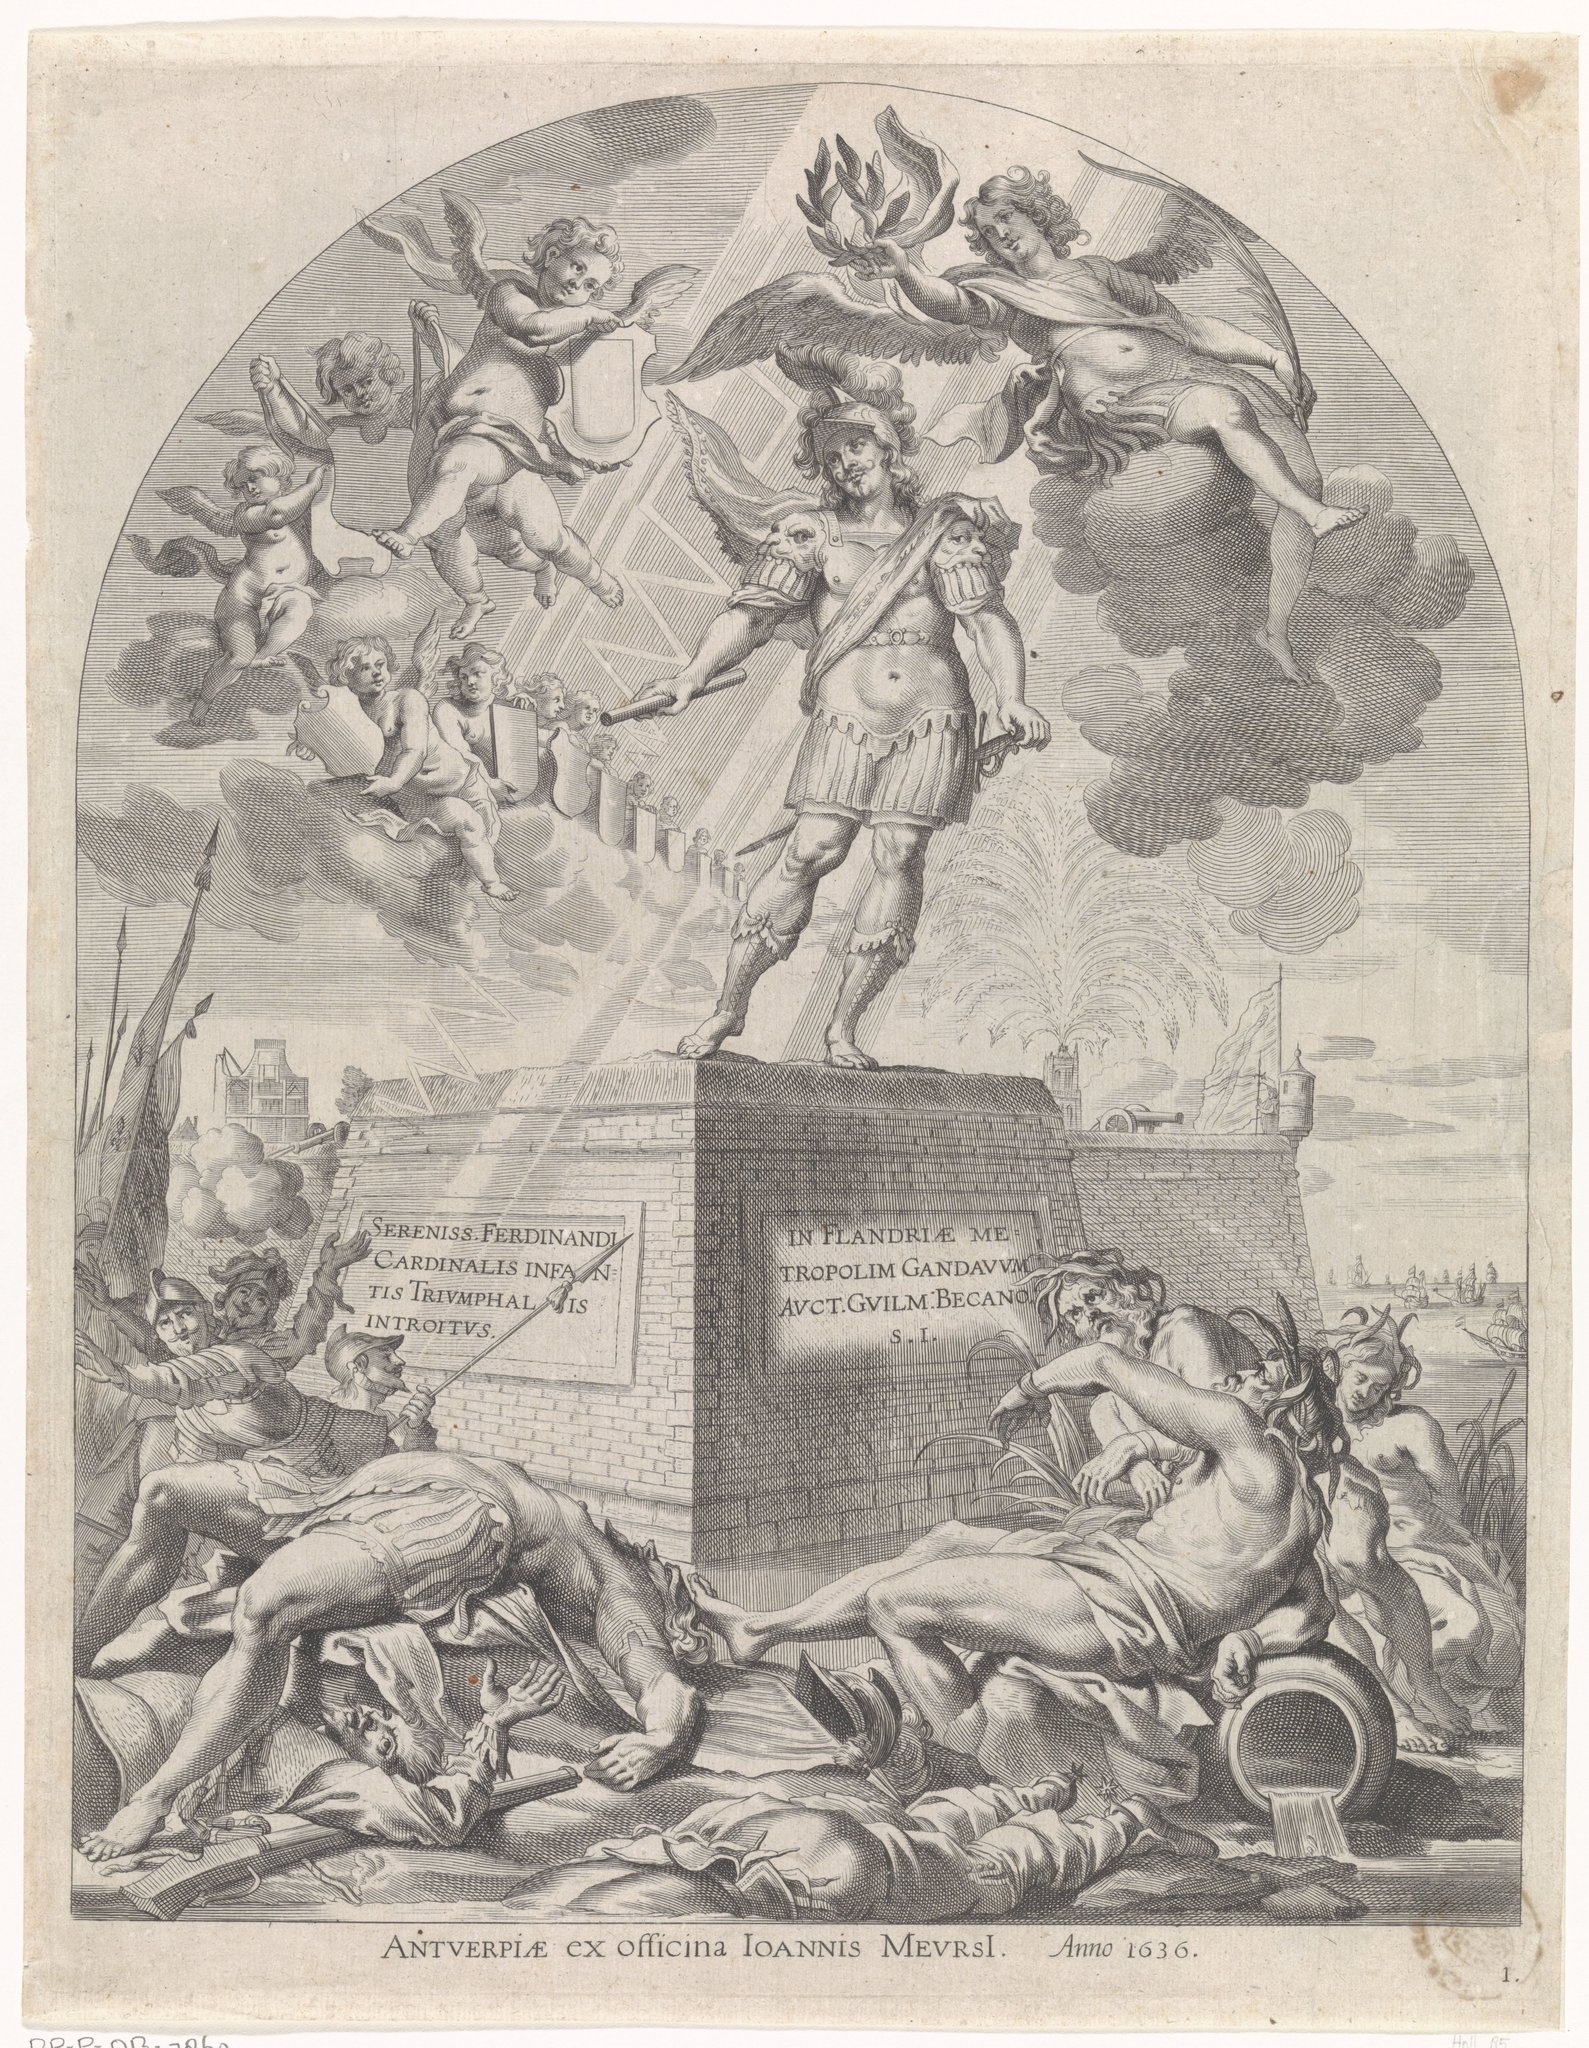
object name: print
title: Sereniss. Ferdinandi Cardinalis Infantis Trivmphal is introitvs in Flandriae (...)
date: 1636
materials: paper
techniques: engraving, etching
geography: antwerp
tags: brussels, landvoogd der zuidelijke nederlanden ferdinand van oostenrijk, river personified, 'fiumi' (ripa), triumphal entry and public reception, pageant, 'entrée solennelle', 'joyeuse entrée', massacre ~ war, ghent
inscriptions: collector's mark: Lugt 240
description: Kardinaal-Infant Ferdinand als Mars, staand op een stadsmuur. In zijn rechterhand houdt hij een commandostaf. Victorie kroont hem met een lauwerkrans. Links diverse engelen met lege wapenschilden. Op de voorgrond verslagen vijanden en drie riviergoden. In het kader op de stadsmuur staat de titel. Titelprent voor een serie van 42 die de uitgave van de beschrijving van de intocht van de Kardinaal Infant Ferdinand van Oostenrijk te Gent op 28 januari 1635 als de nieuwe landvoogd voor de Spaanse Nederlanden illustreren.